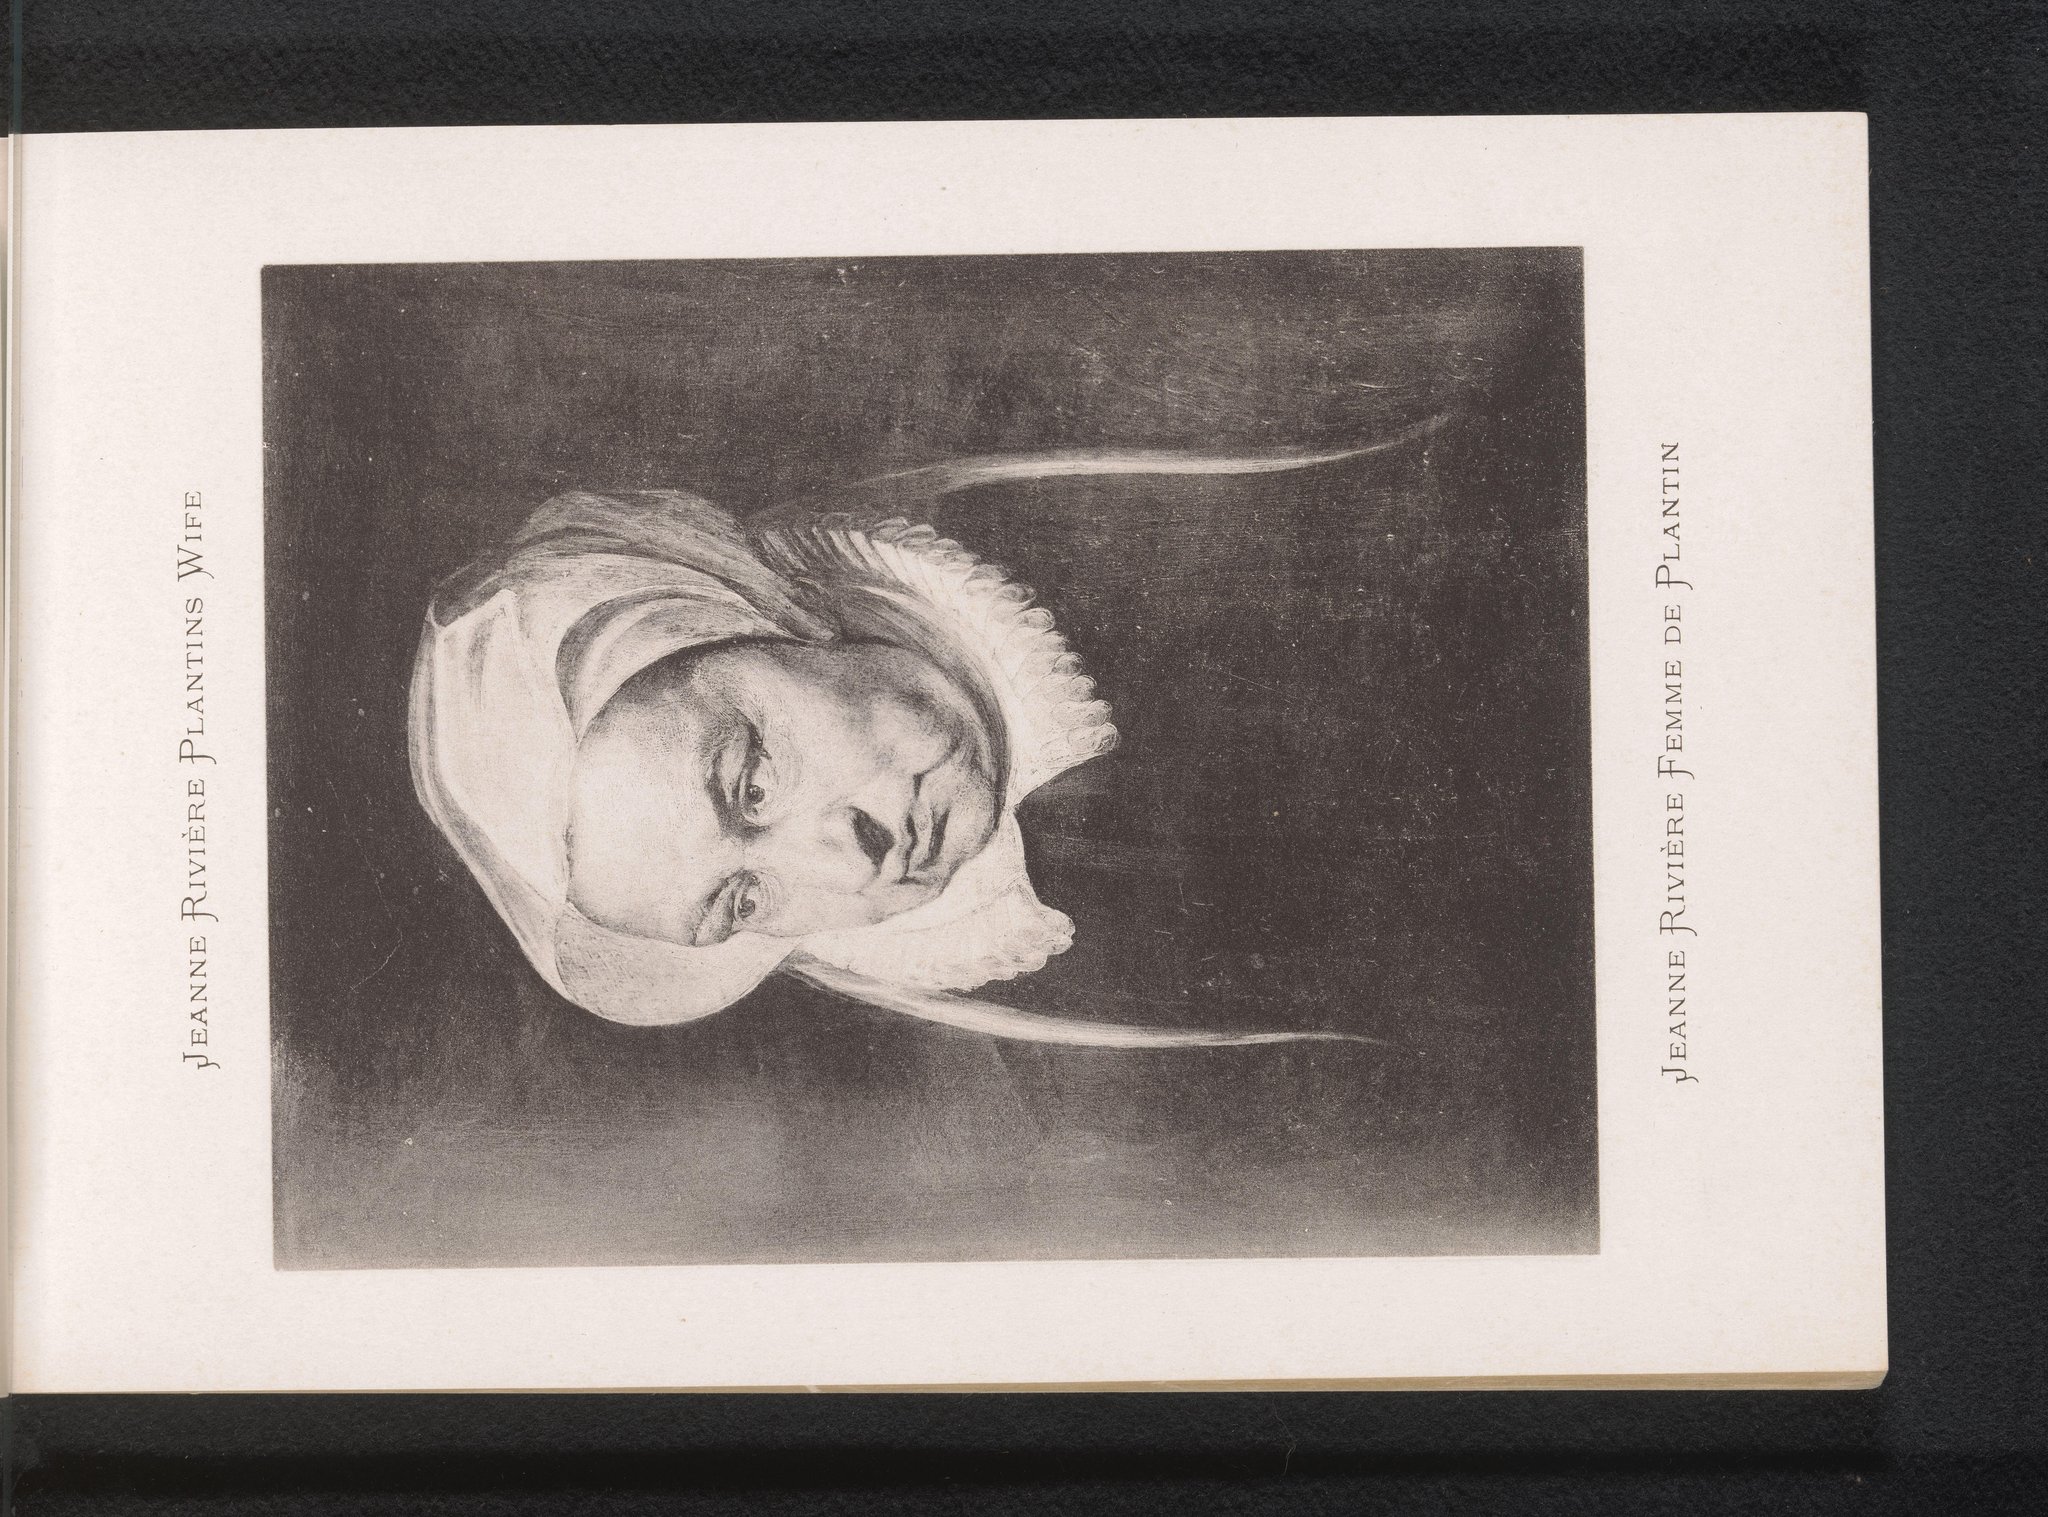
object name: page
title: Jeanne Rivière femme de Plantin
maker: Anonymous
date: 1892-1897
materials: paper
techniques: photograph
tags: adult woman